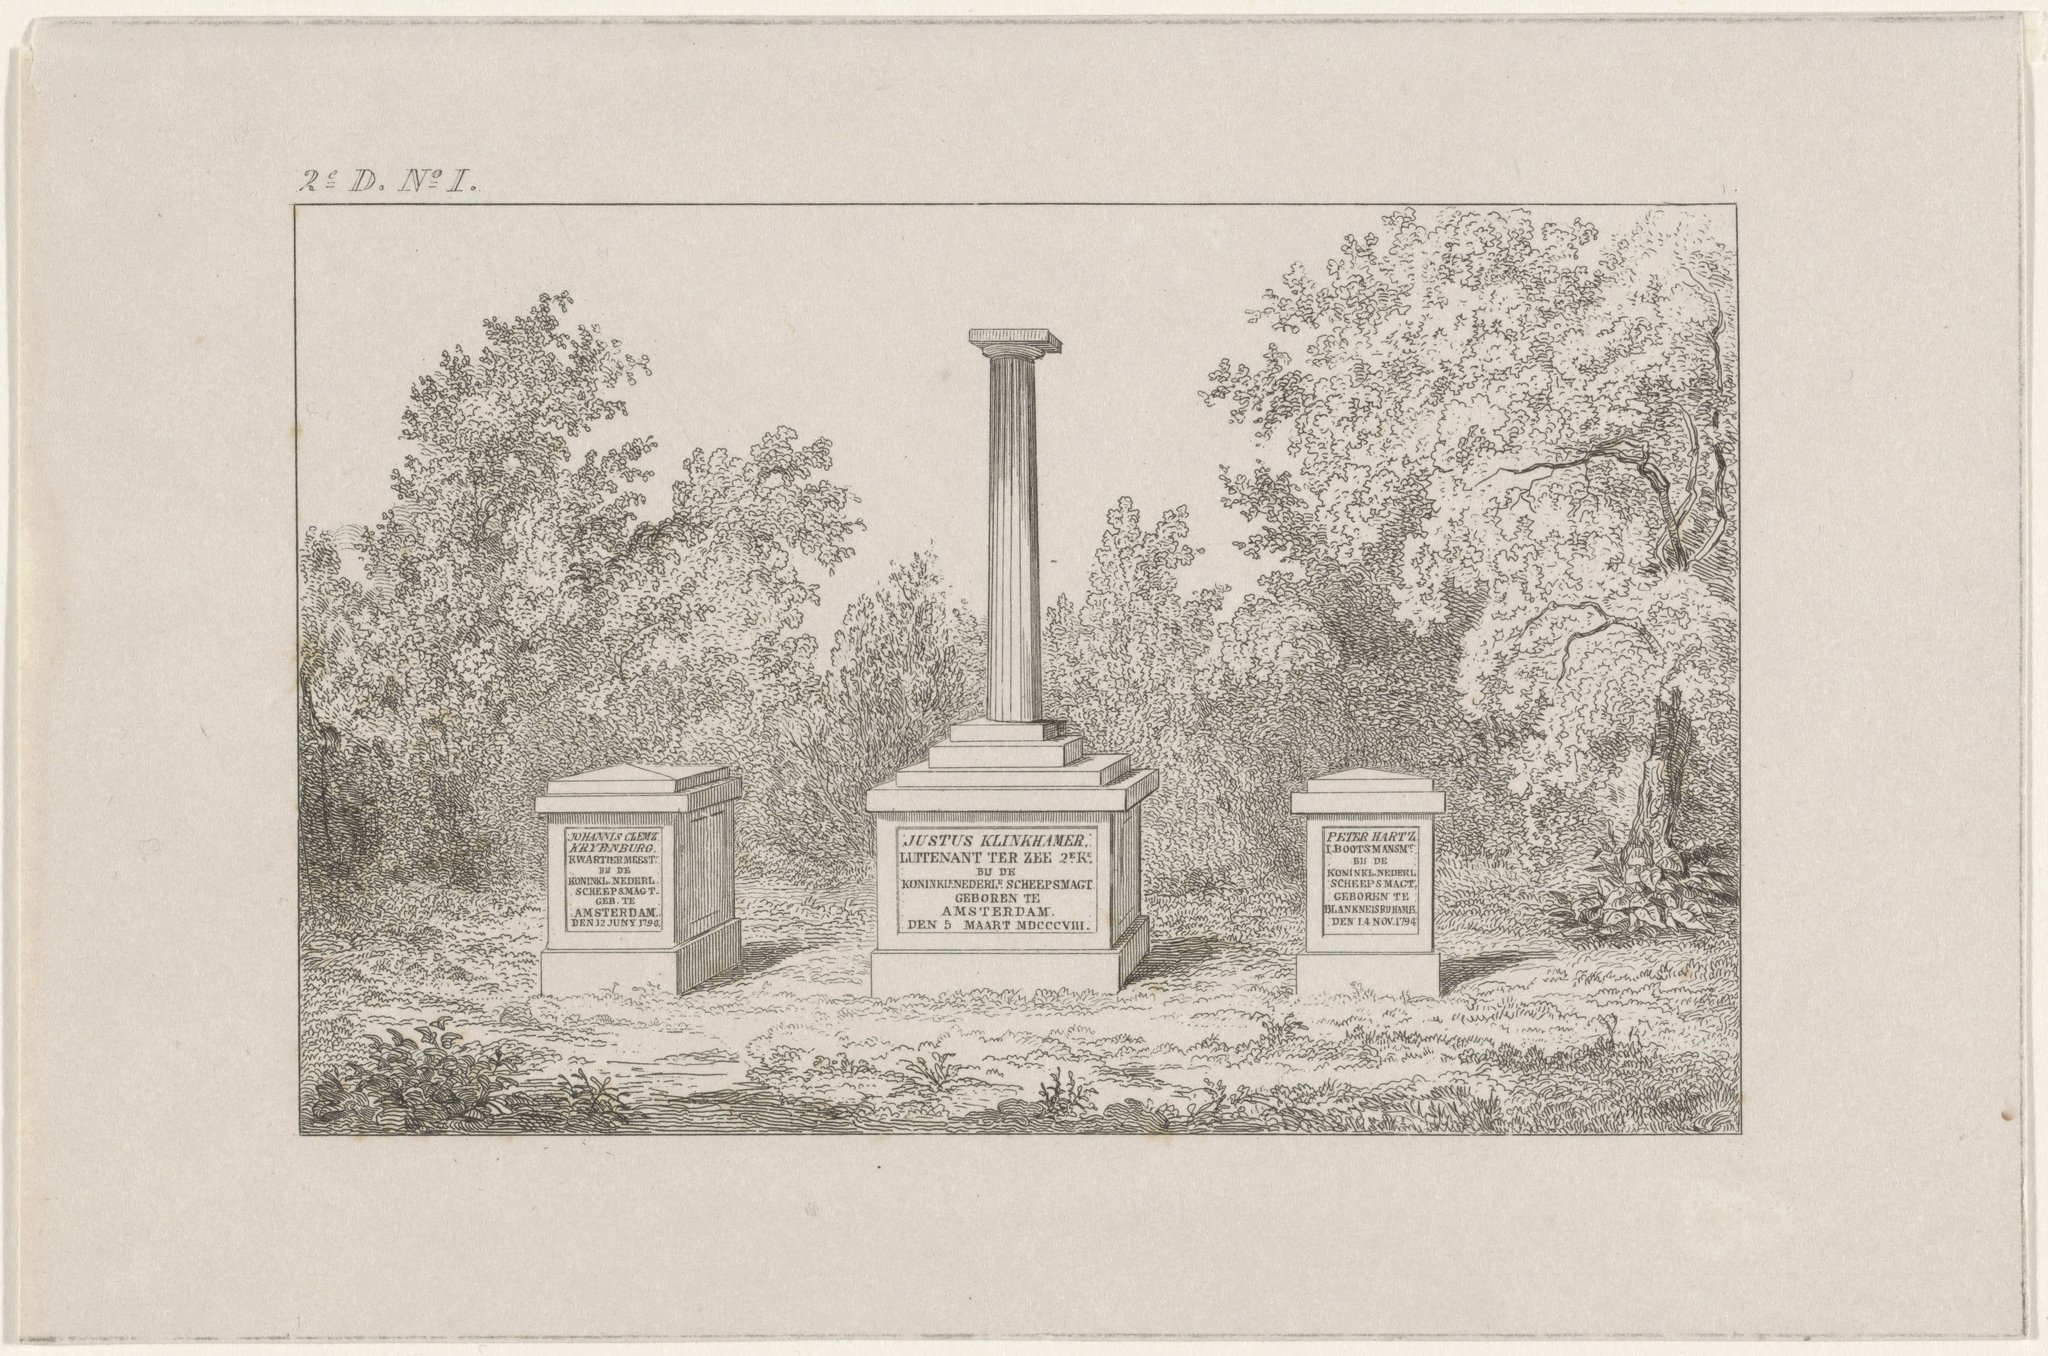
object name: print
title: Grafmonumenten voor Klinkhamer, Kreijenburg en Hartz, 1830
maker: Anonymous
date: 1838-1840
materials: paper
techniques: etching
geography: netherlands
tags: amsterdam, grave, tomb, flushing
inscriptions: collector's mark: Lugt 2228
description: Kerkhof te Vlissingen met de drie grafmonumenten voor Justus Klinkhamer, Johannes Clemz. Kreijenburg (of Kryenburg) en Peter Hartz. Allen Nederlandse militairen bij de marine gestorven tijdens of na het bombardement op Antwerpen op 27 oktober 1830. Het monument voor Klinkhamer in de vorm van een zuil op een voetstuk. Gemerkt linksboven: 2e D. No. I.